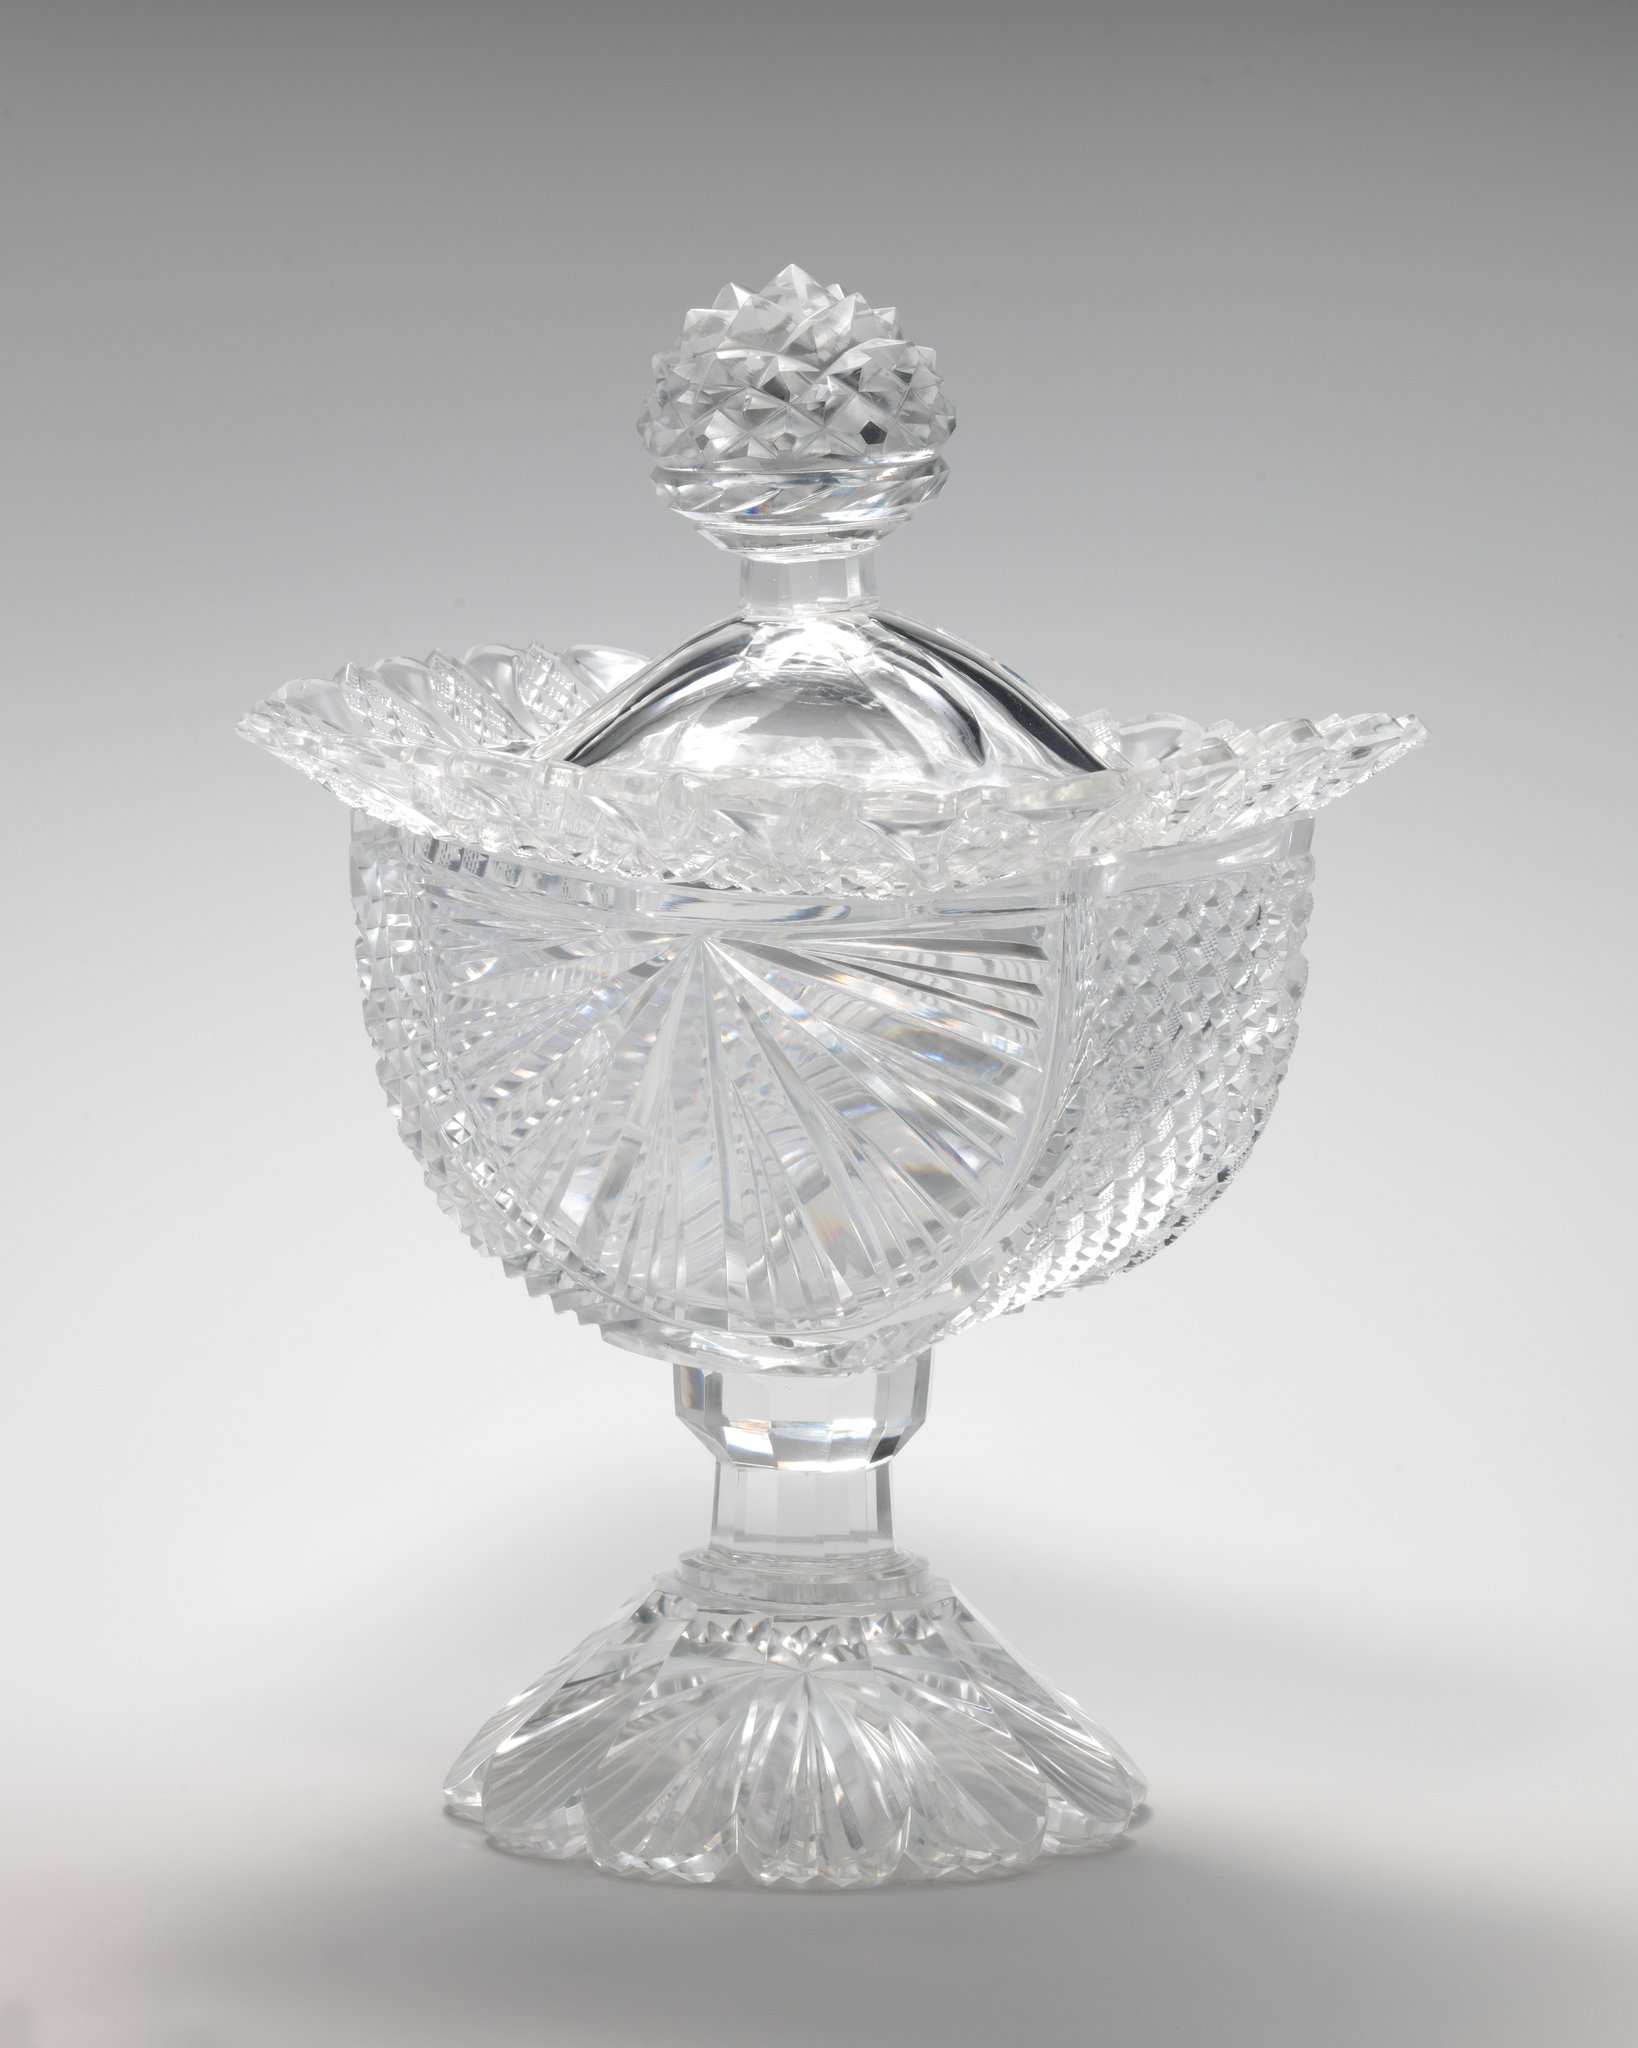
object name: bowl with cover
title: Bowl with cover (one of a pair)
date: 1801-1900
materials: glass